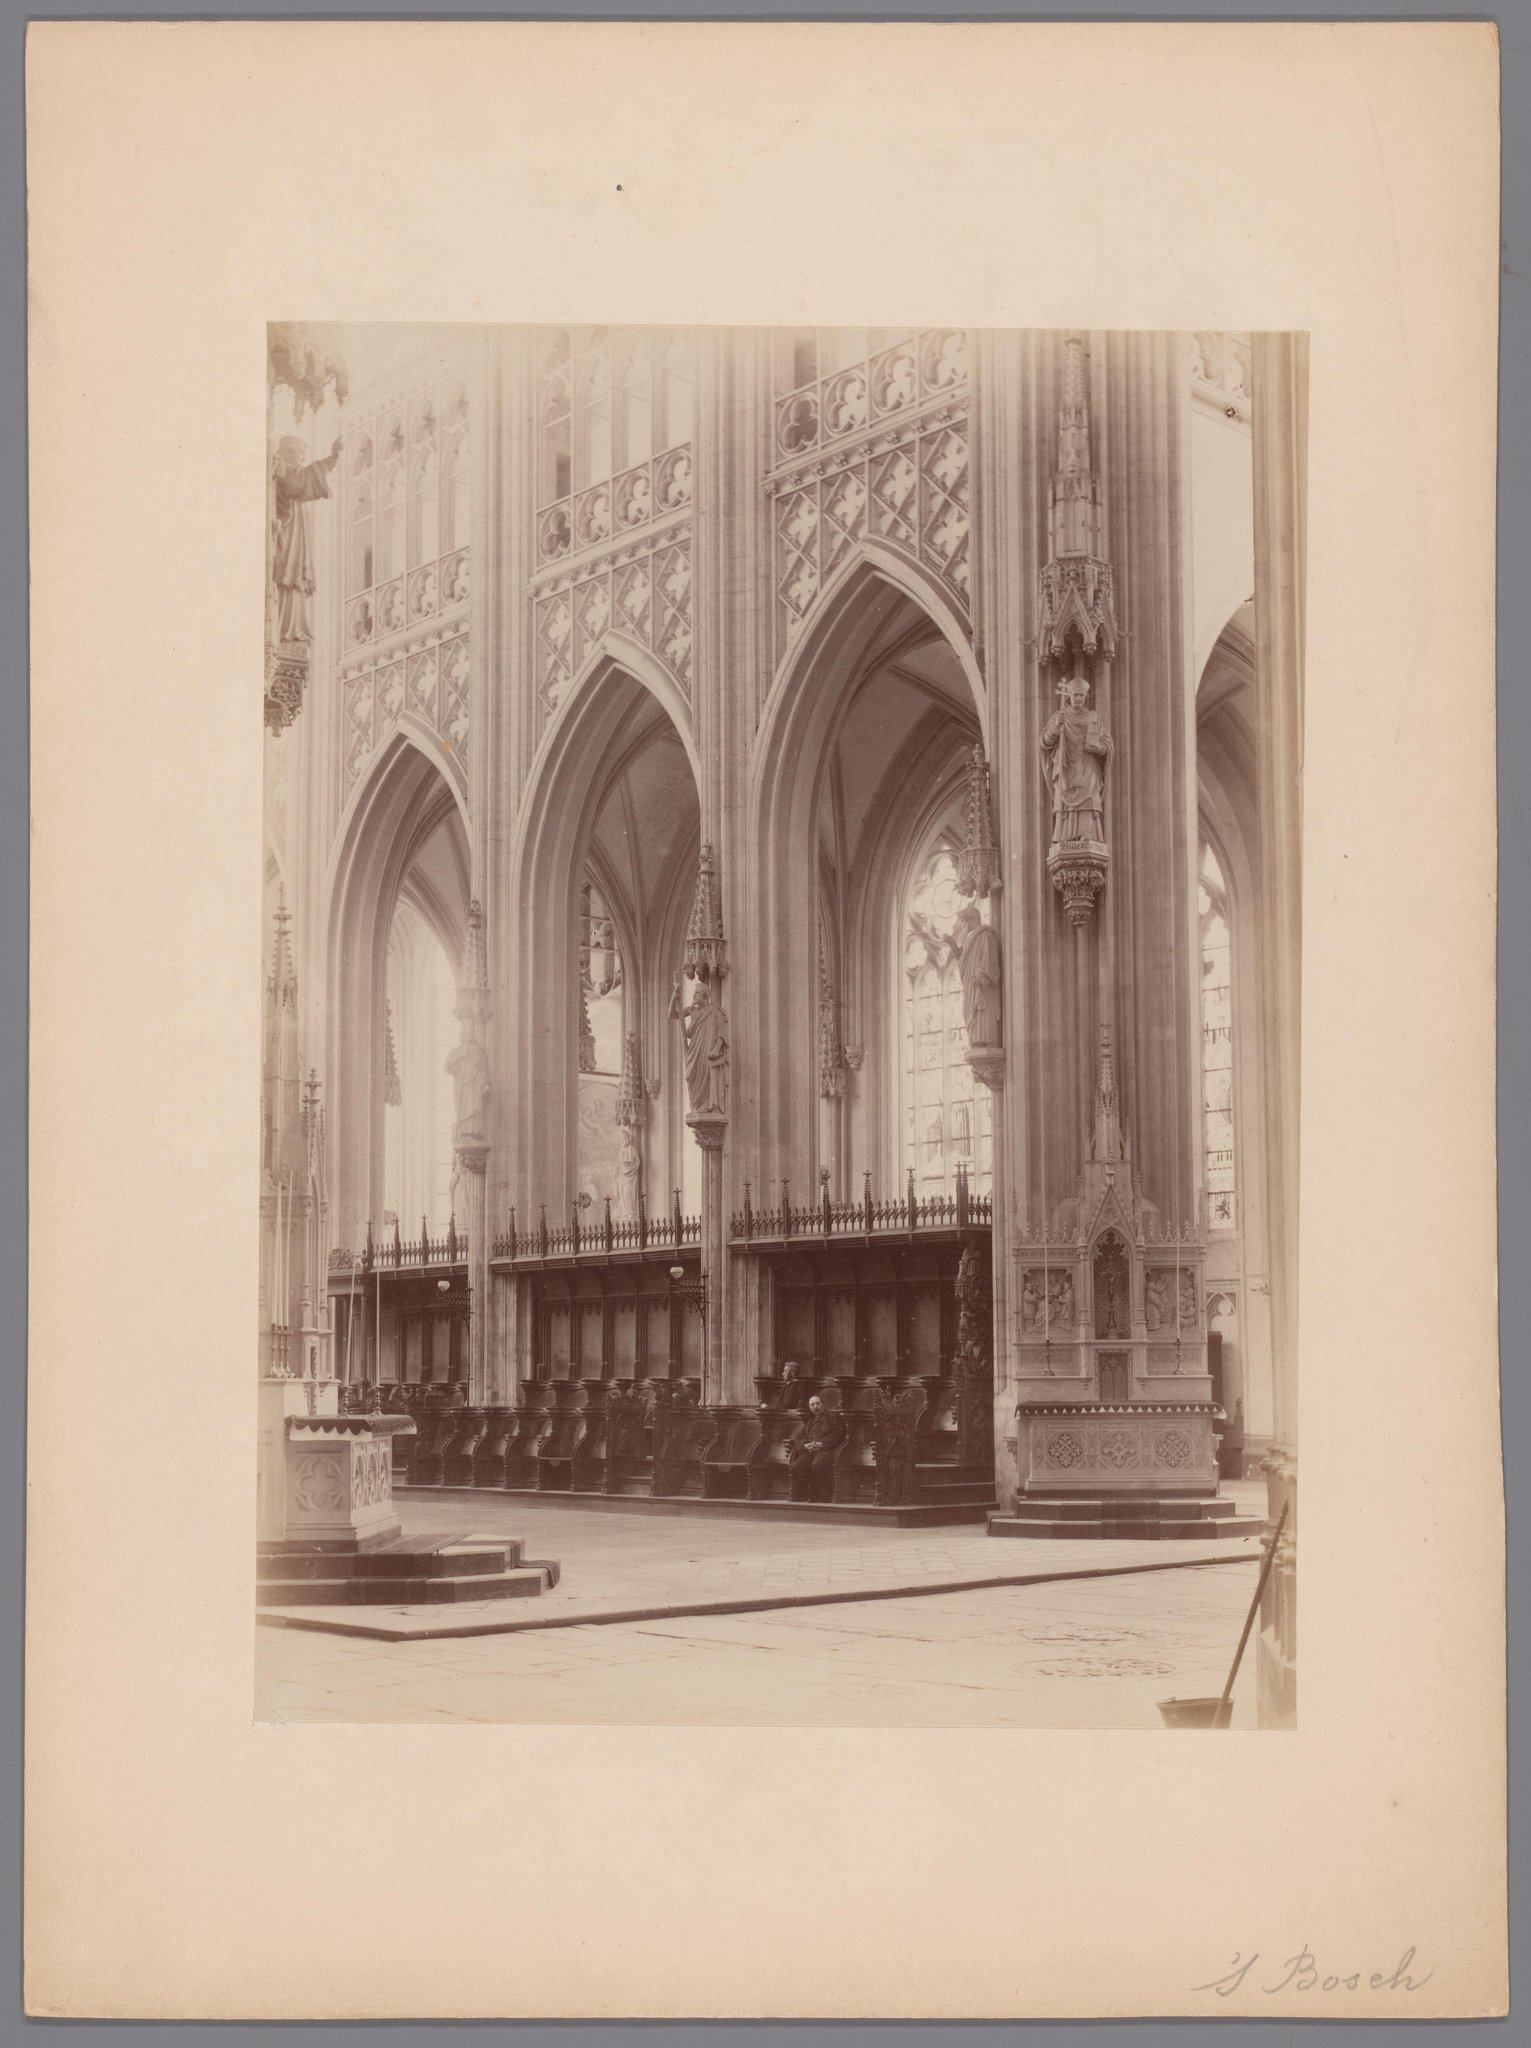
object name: photograph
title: Gezicht op de koorbanken in de Sint-Janskathedraal te Den Bosch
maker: anoniem (monumentenzorg)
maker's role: fotograaf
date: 1890-1920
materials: cardboard, photographic support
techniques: albumen print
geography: sint-janskathedraal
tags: parts of church interior: choir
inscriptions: annotation: ‘'s Bosch’, annotation: ‘S. Janskerk te s Bosch/ gezicht op de koorbanken in het koor’